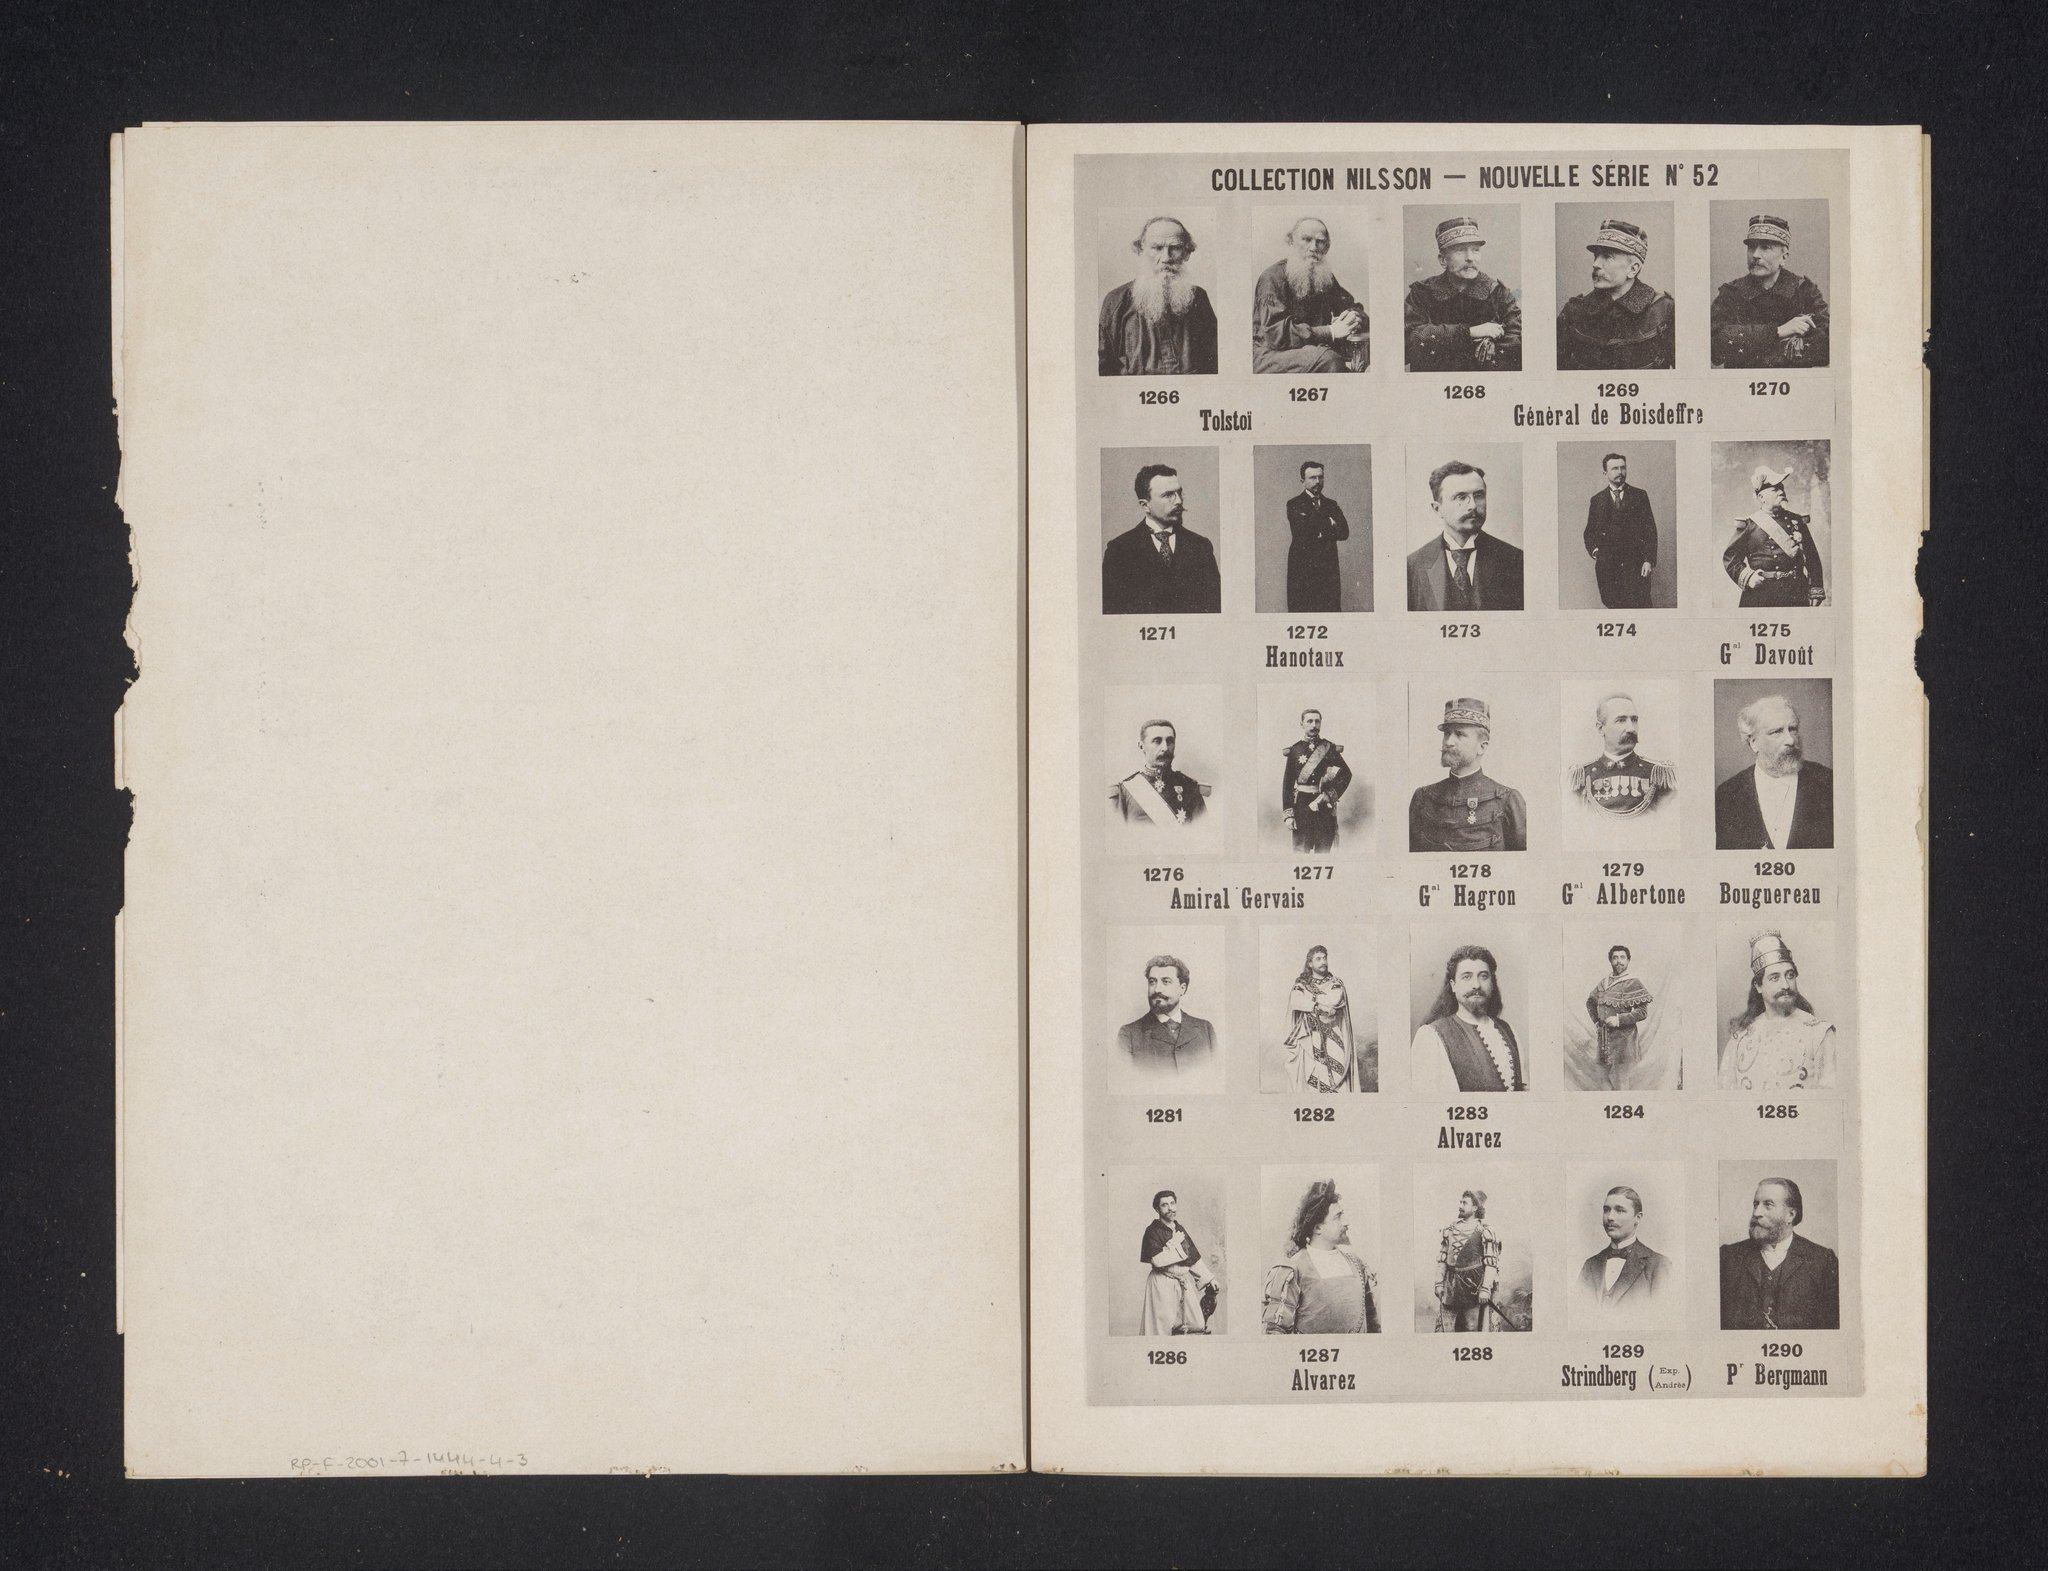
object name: photomechanical print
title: 25 portretten van Tolstoj, Raoul de Boisdeffre en anderen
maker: Anonymous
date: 1892-1897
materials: paper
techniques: photograph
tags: historical persons - bb - woman, historical persons, portrait of a writer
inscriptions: number: ‘No 52’, inscription: ‘Tolstoï Génèral de Boisdeffre/ Hanotaux Gal Davoût/ Amiral Gervais Gal Hagron Gal Albertone Bouguereau/ Alvarez/ Alvarez Strindberg (Exp. Andrée) Pr Bergmann’